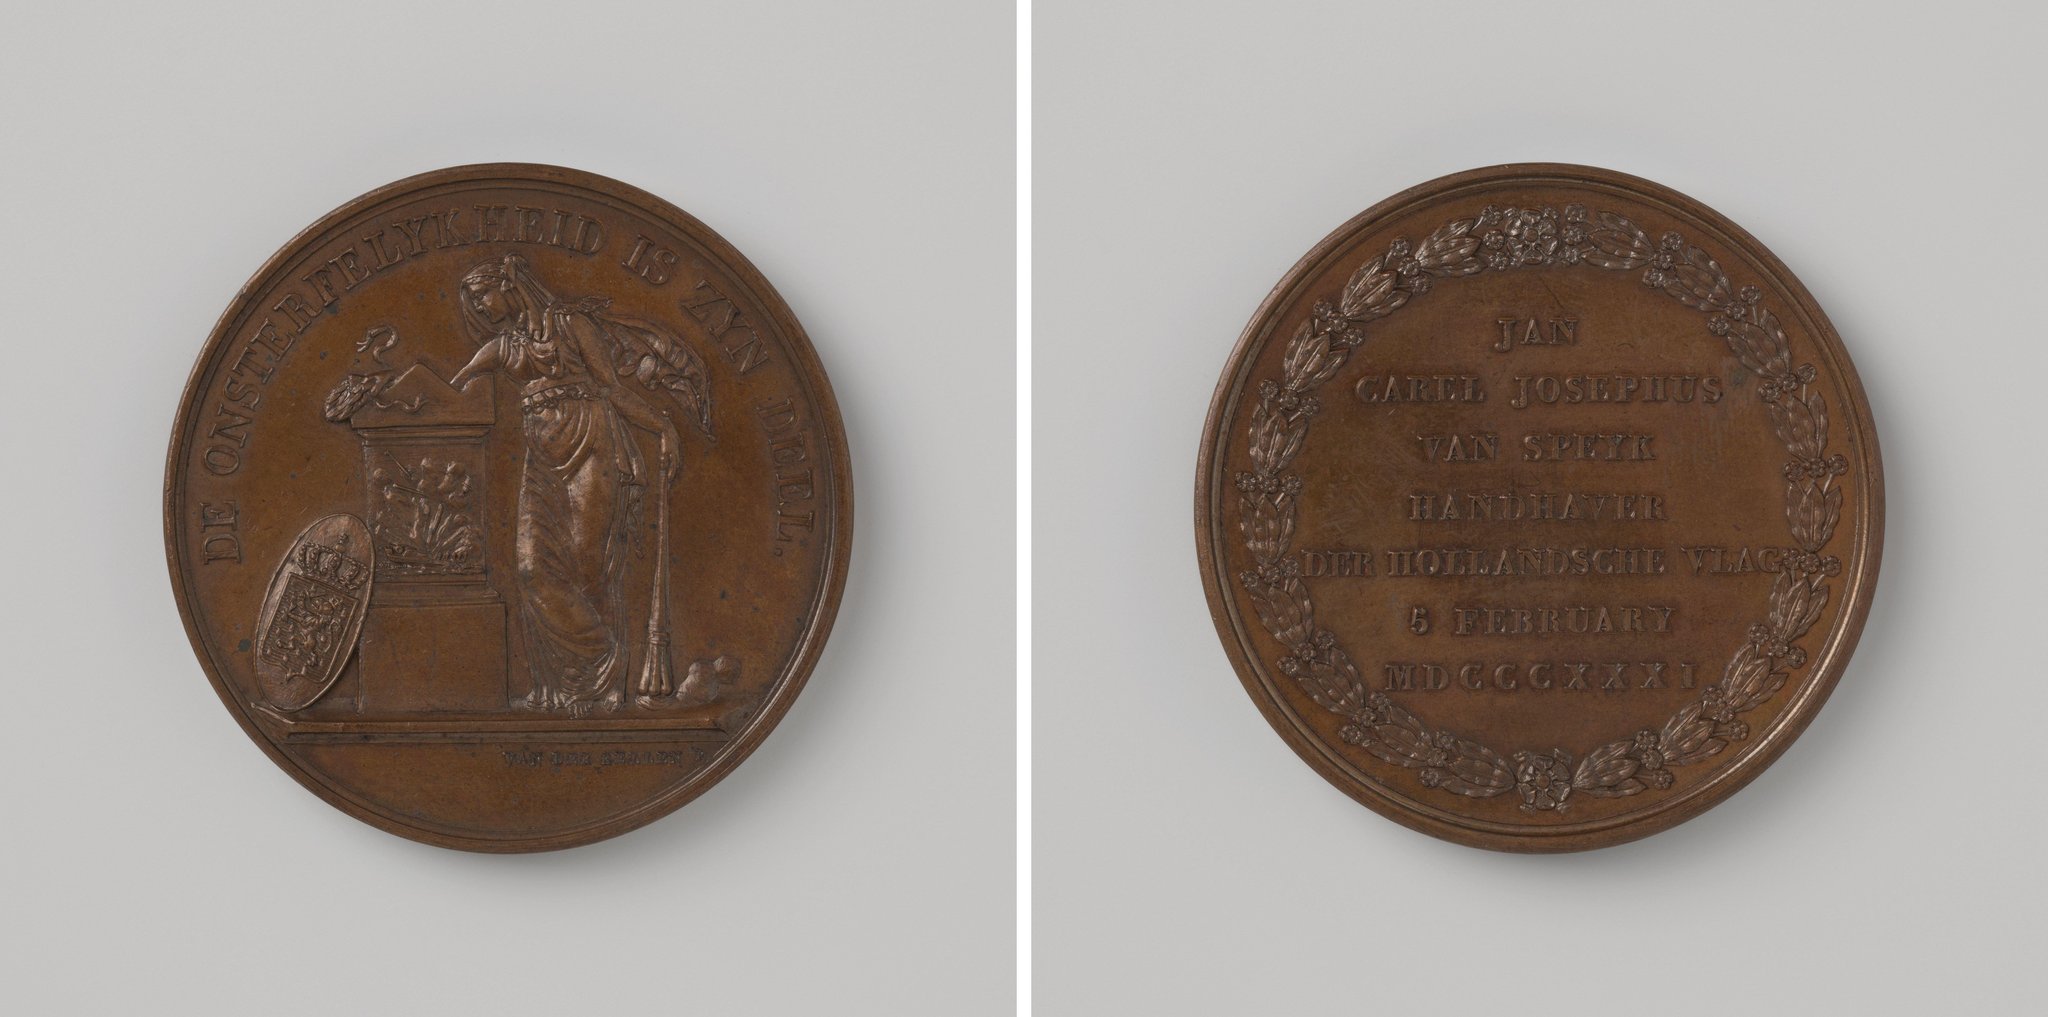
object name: history medal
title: Heldendood van Jan Carel Josephus van Speyk 1831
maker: david van der kellen (1804-1879)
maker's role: die cutter, draughtsman, print maker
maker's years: 1804-1879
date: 1831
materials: bronze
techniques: striking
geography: utrecht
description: Bronzen penning, op de voorzijde Nederland, als treurende vrouw met uitgedoofde fakkel, een krans plaatsend op een grafmonument waarop afgebeeld een exploderend schip en waartegen een ovaal schild met het Nederlandse wapen, met omschrift.